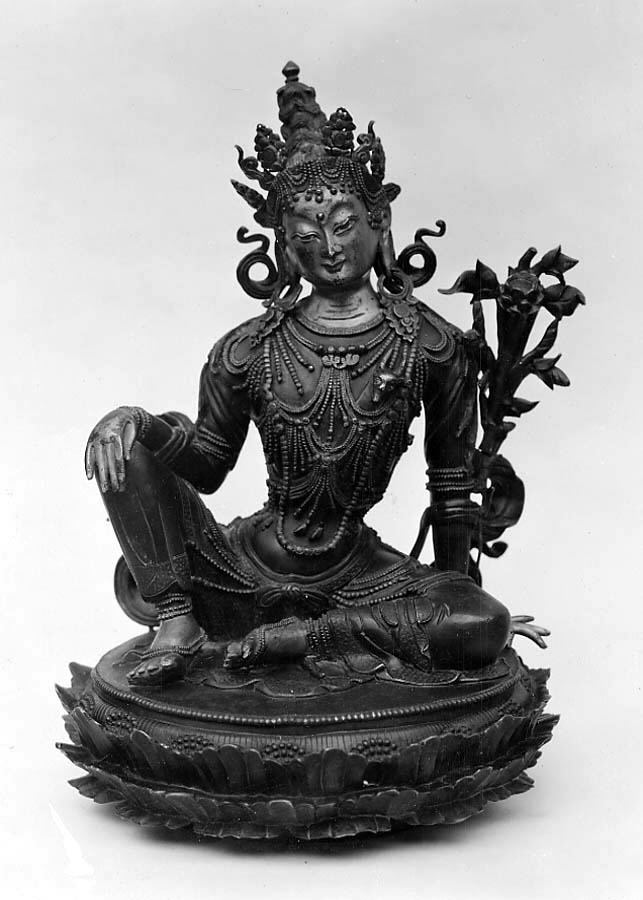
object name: figure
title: Seated Padmapani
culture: tibetan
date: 1601-1800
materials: bronze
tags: buddhism,deities